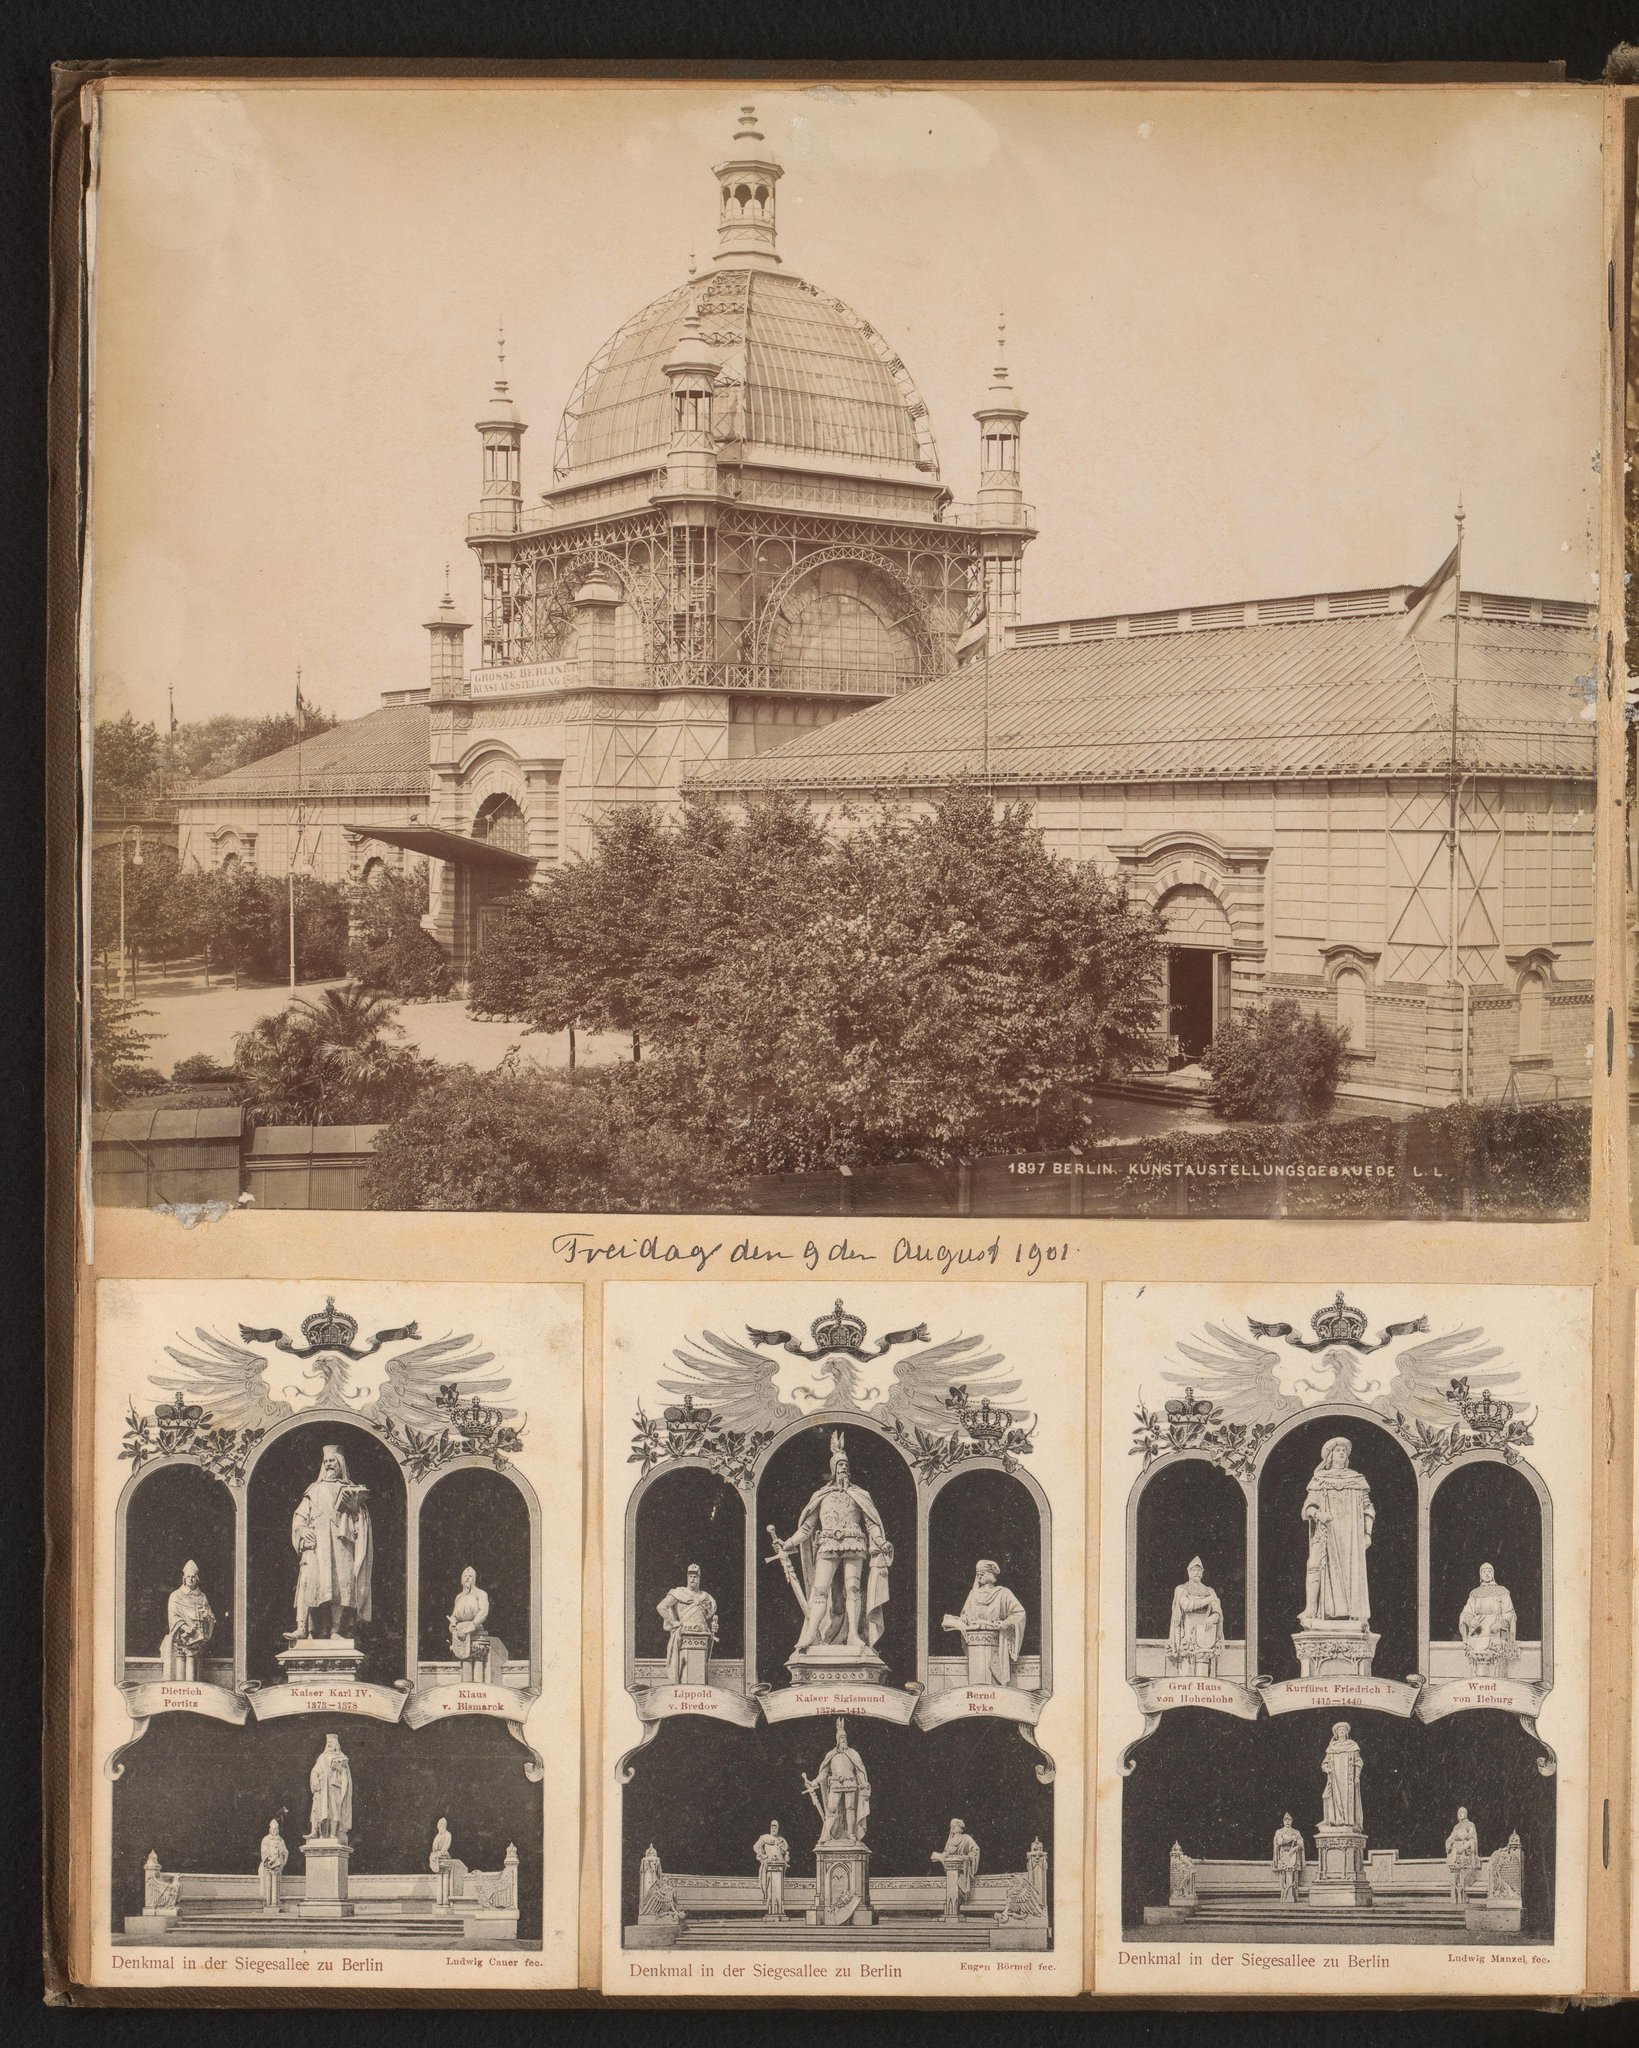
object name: photomechanical print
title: Gebouw van de Berliner Kunstaustellung en beelden langs de Siegesallee, Berlijn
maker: Anonymous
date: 1896-1901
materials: paper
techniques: albumen print, photograph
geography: berlin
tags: piece of sculpture, reproduction of a piece of sculpture, exhibition ~ art, berlin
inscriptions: title: ‘1897 Berlin. Kunstausstellungsgebauede. L.L.’, inscription: ‘Denkmal in der Siegesallee zu Berlin (...)’, inscription: ‘Freidag den 9den August 1901’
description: Deze foto en fotomechanische afdrukken maken deel uit van een album.